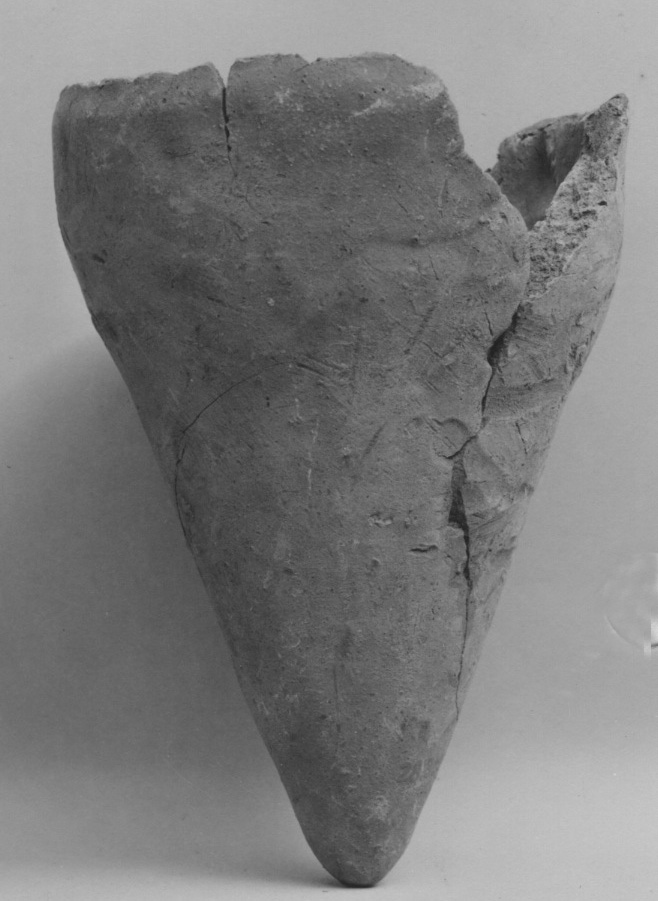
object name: jar stopper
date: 2051-2000 BCE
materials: mud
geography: egypt